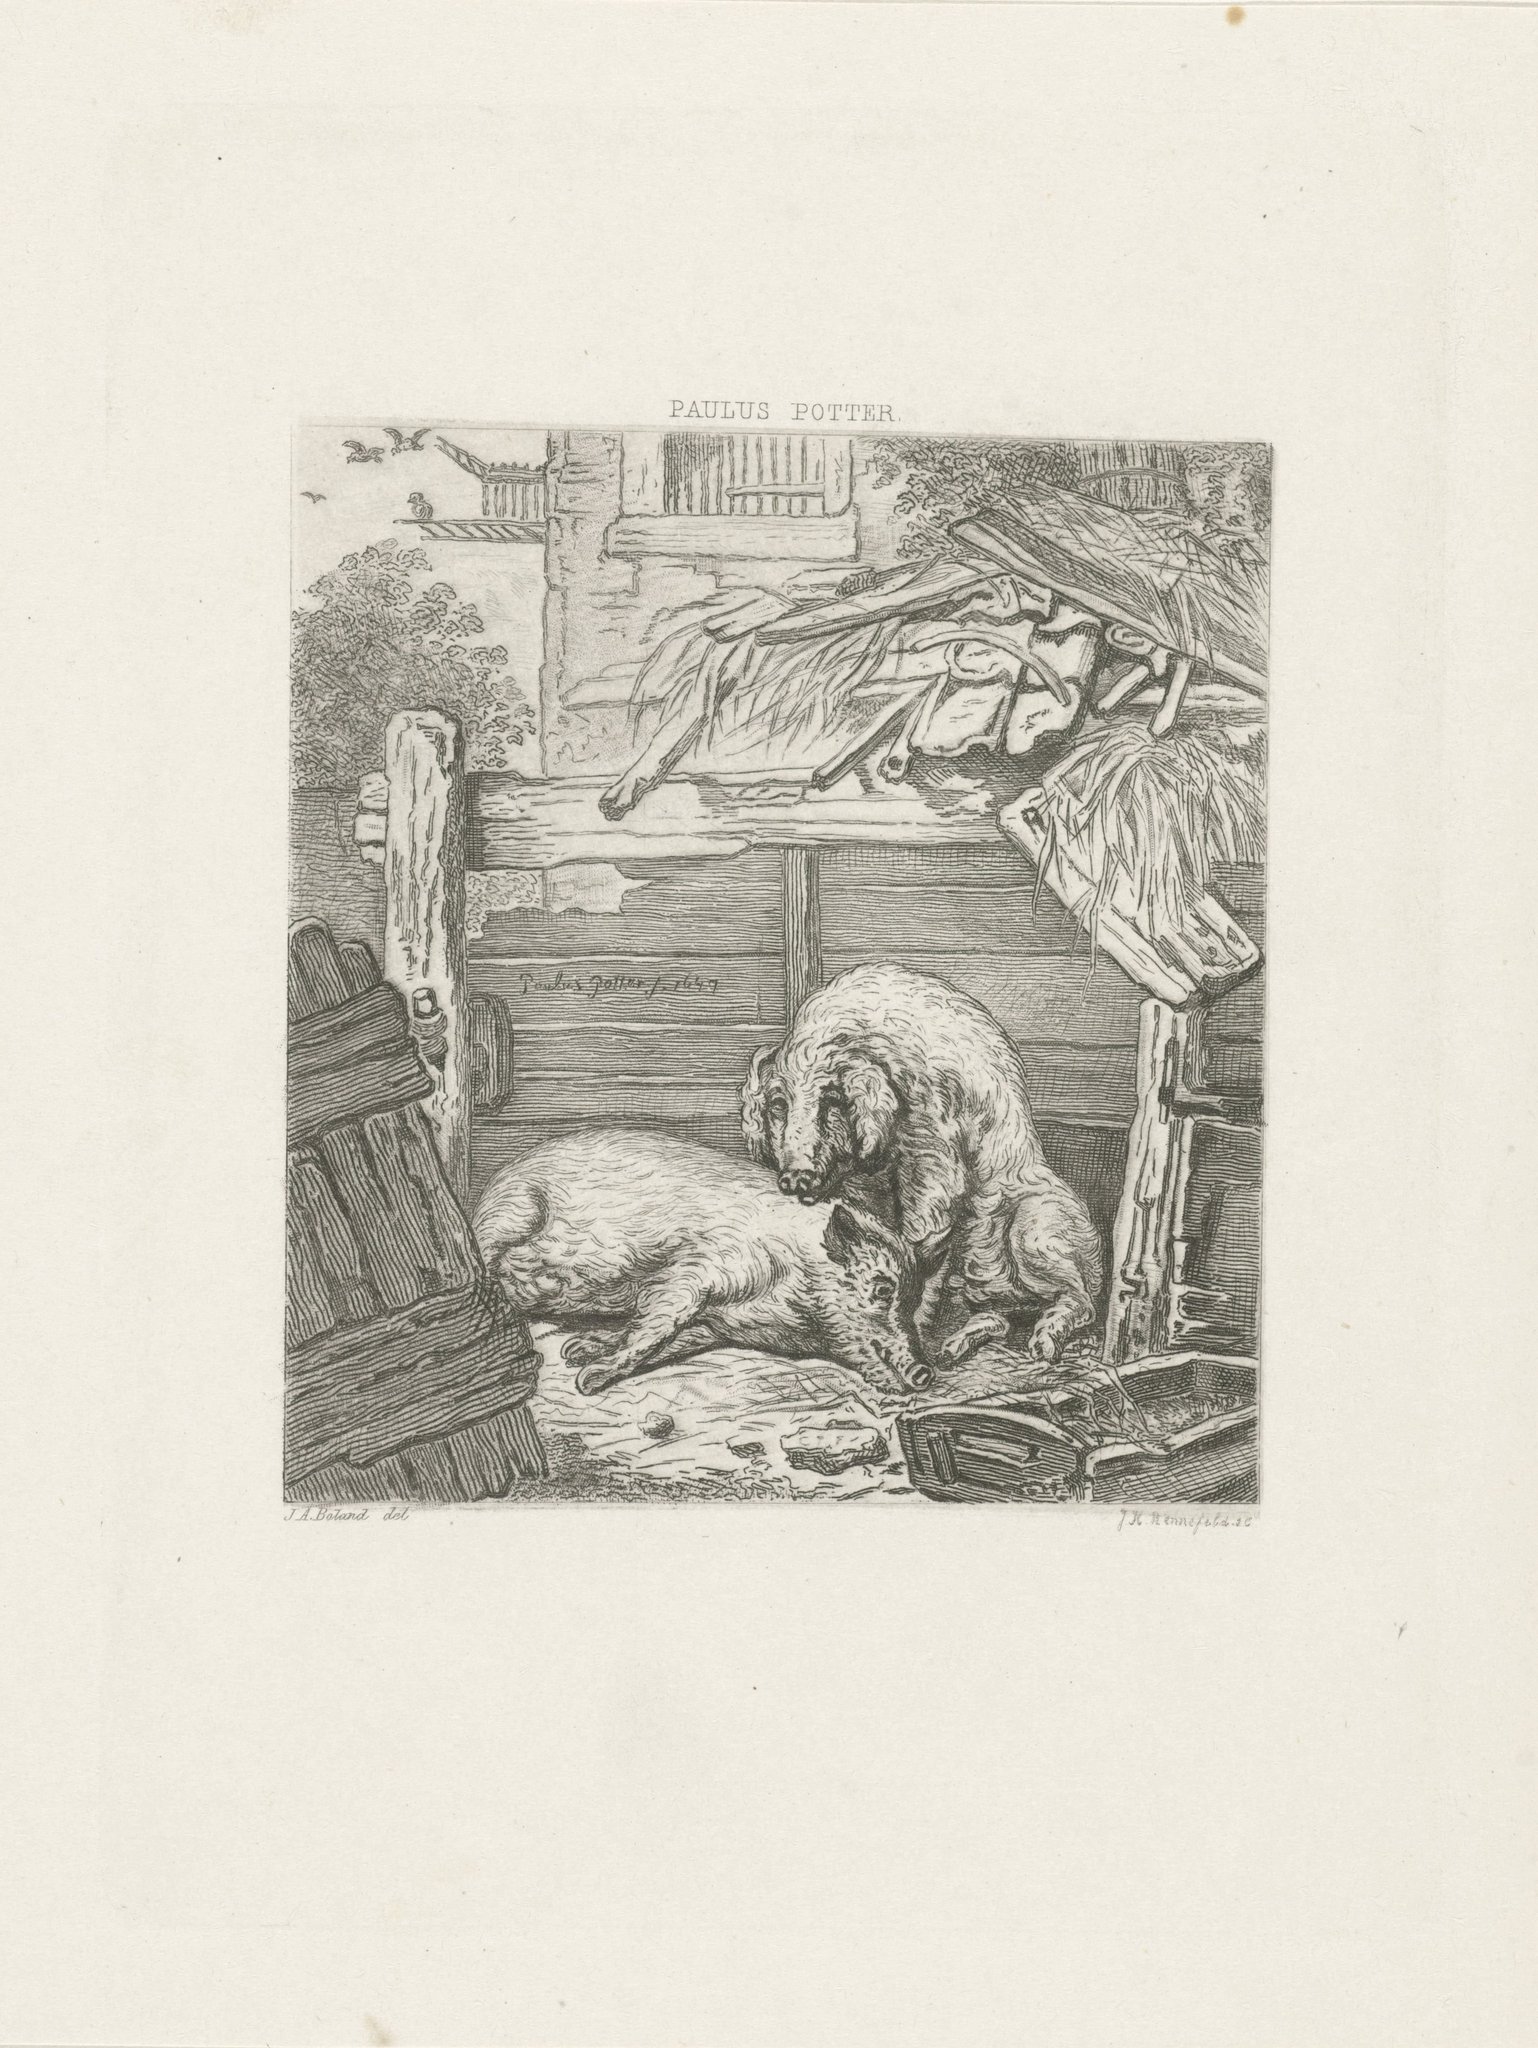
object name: print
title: Varkenskot met twee varkens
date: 1845-1877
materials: paper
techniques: etching, roulette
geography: amsterdam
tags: pig